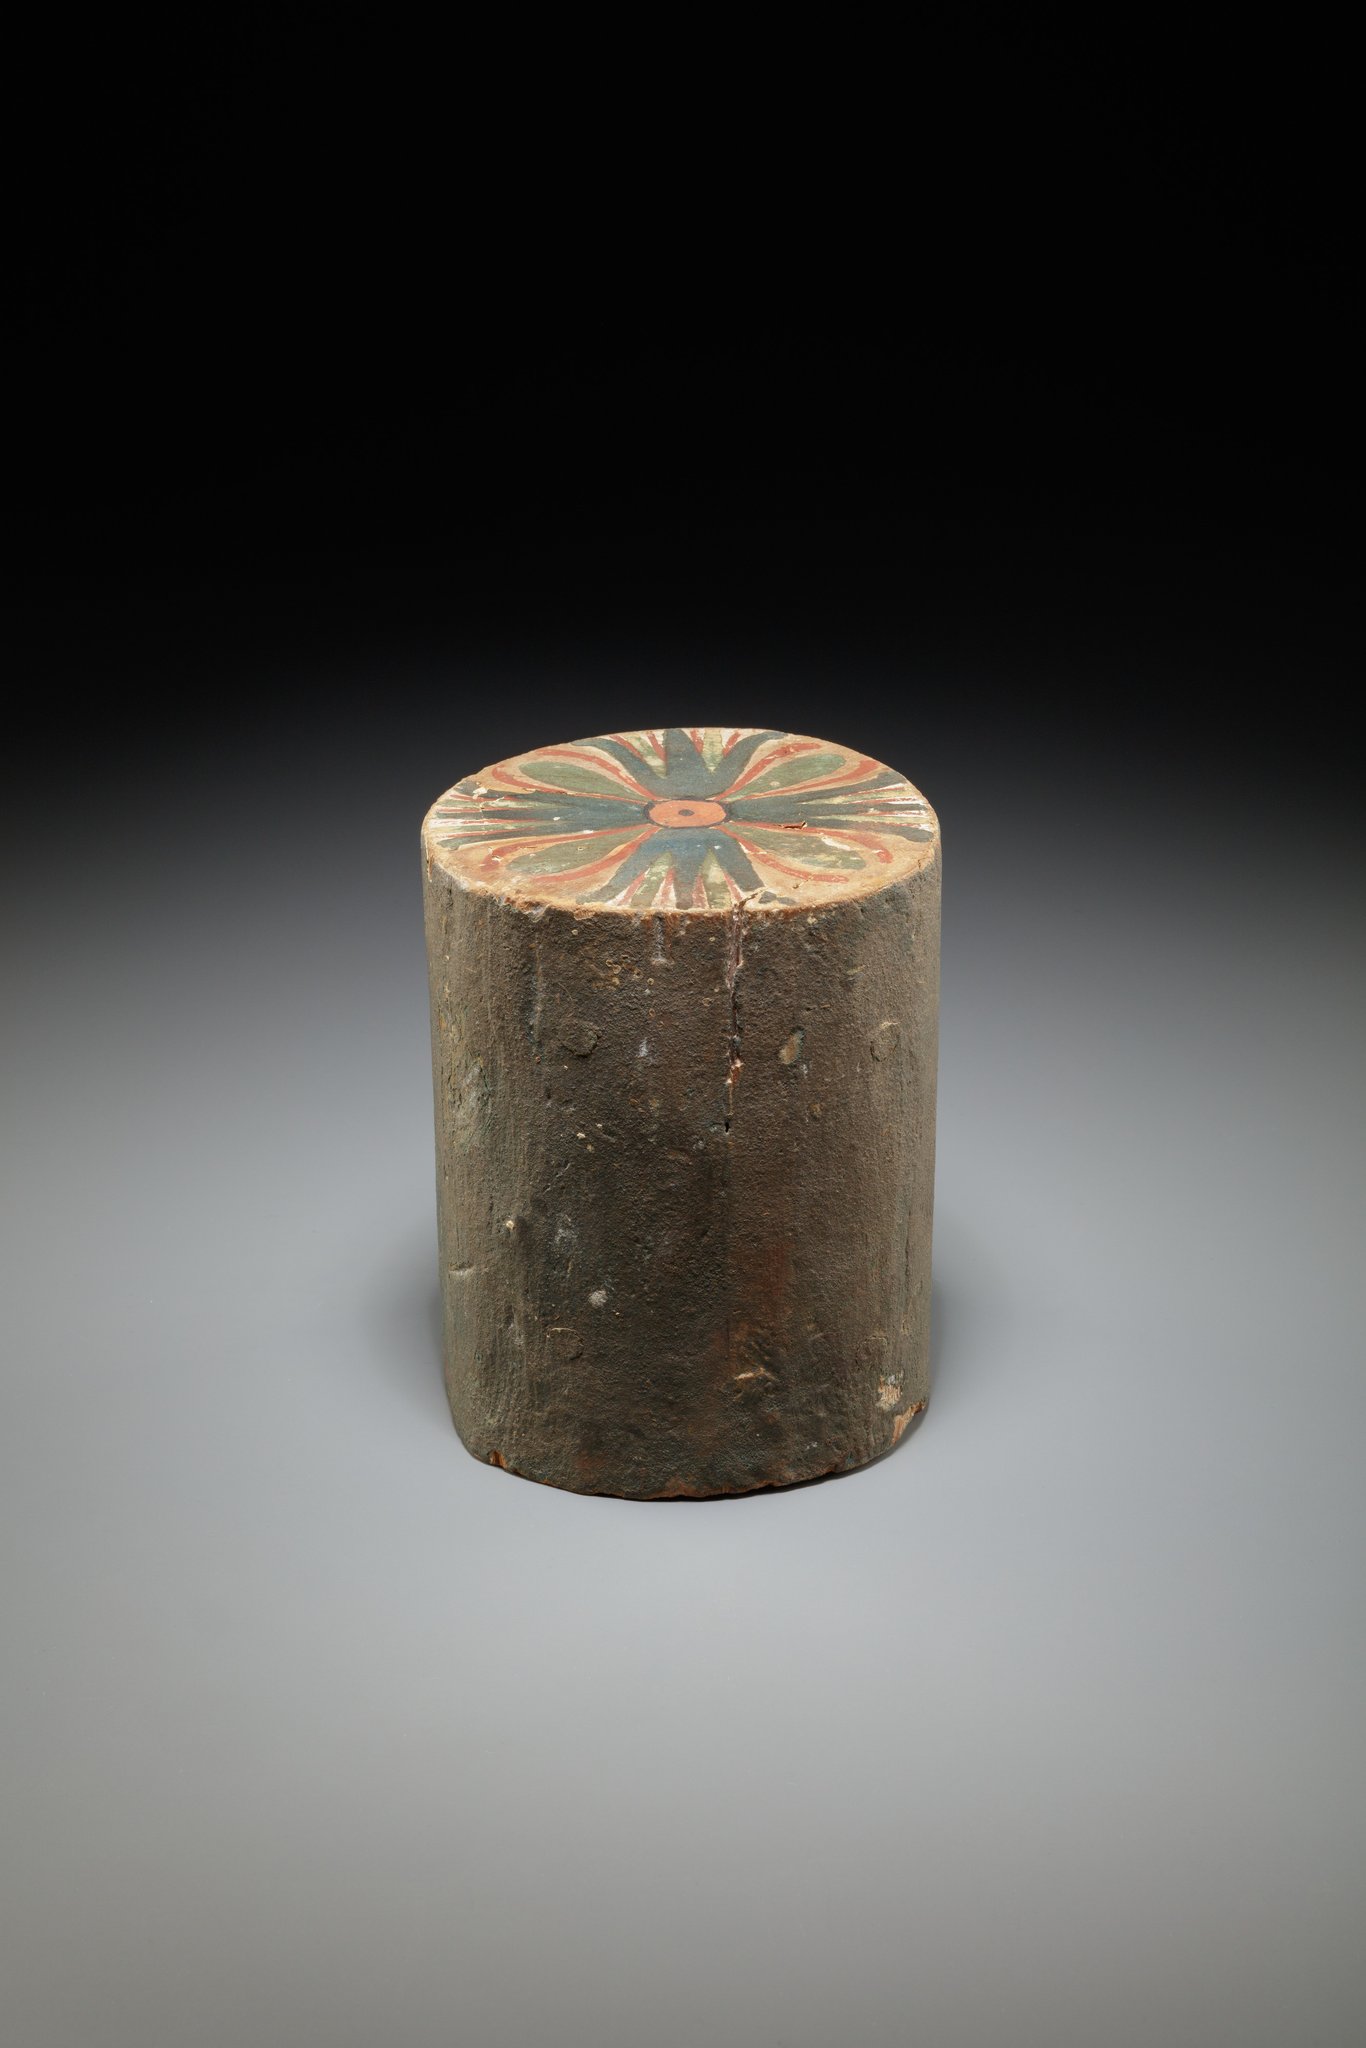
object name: coffin knob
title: Coffin knob (?)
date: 1981-1550 BCE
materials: paint, wood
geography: egypt